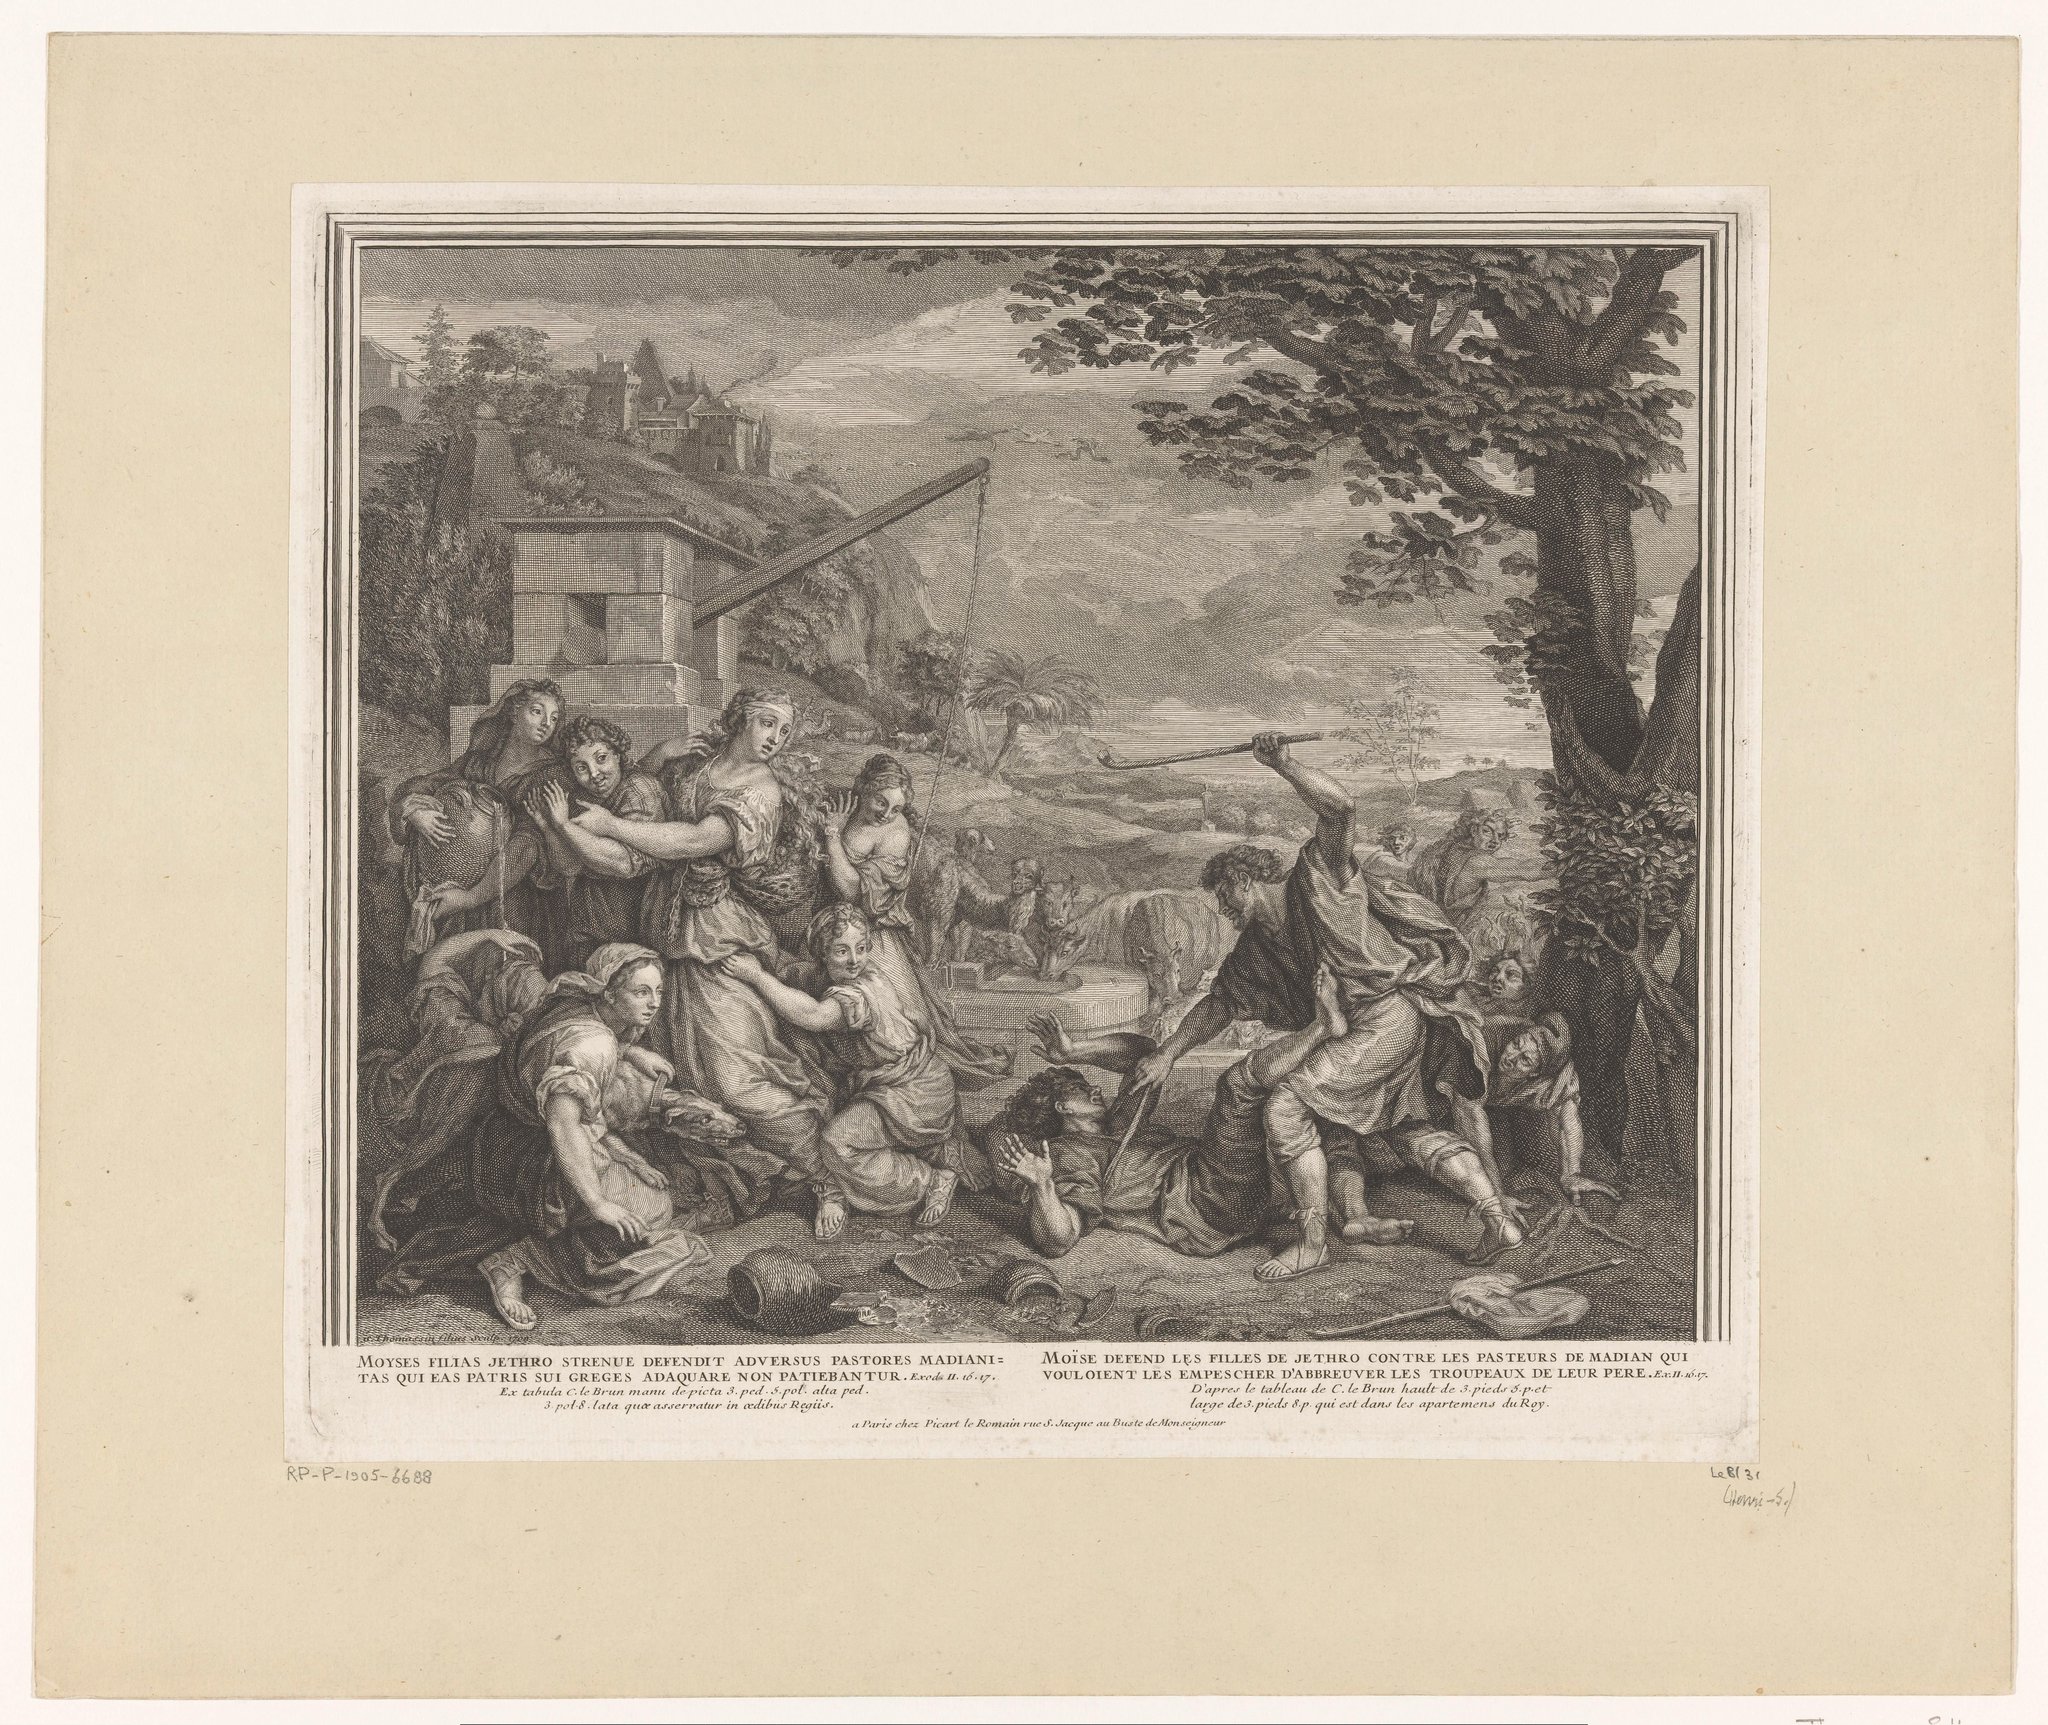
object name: print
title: Mozes en de dochters van Reüel (Jetro) bij de put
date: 1709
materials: paper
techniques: engraving, etching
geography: paris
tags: well, cattle, moses drives away the shepherds who wanted to prevent jethro's daughters from watering their father's flock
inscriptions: collector's mark: Lugt 2228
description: Aan de rechterzijde schiet Mozes de zeven dochters van Reüel (Jetro) te hulp en verjaagt de herders bij de waterput. Het vee van Reüel op de achtergrond drinkt uit de put.